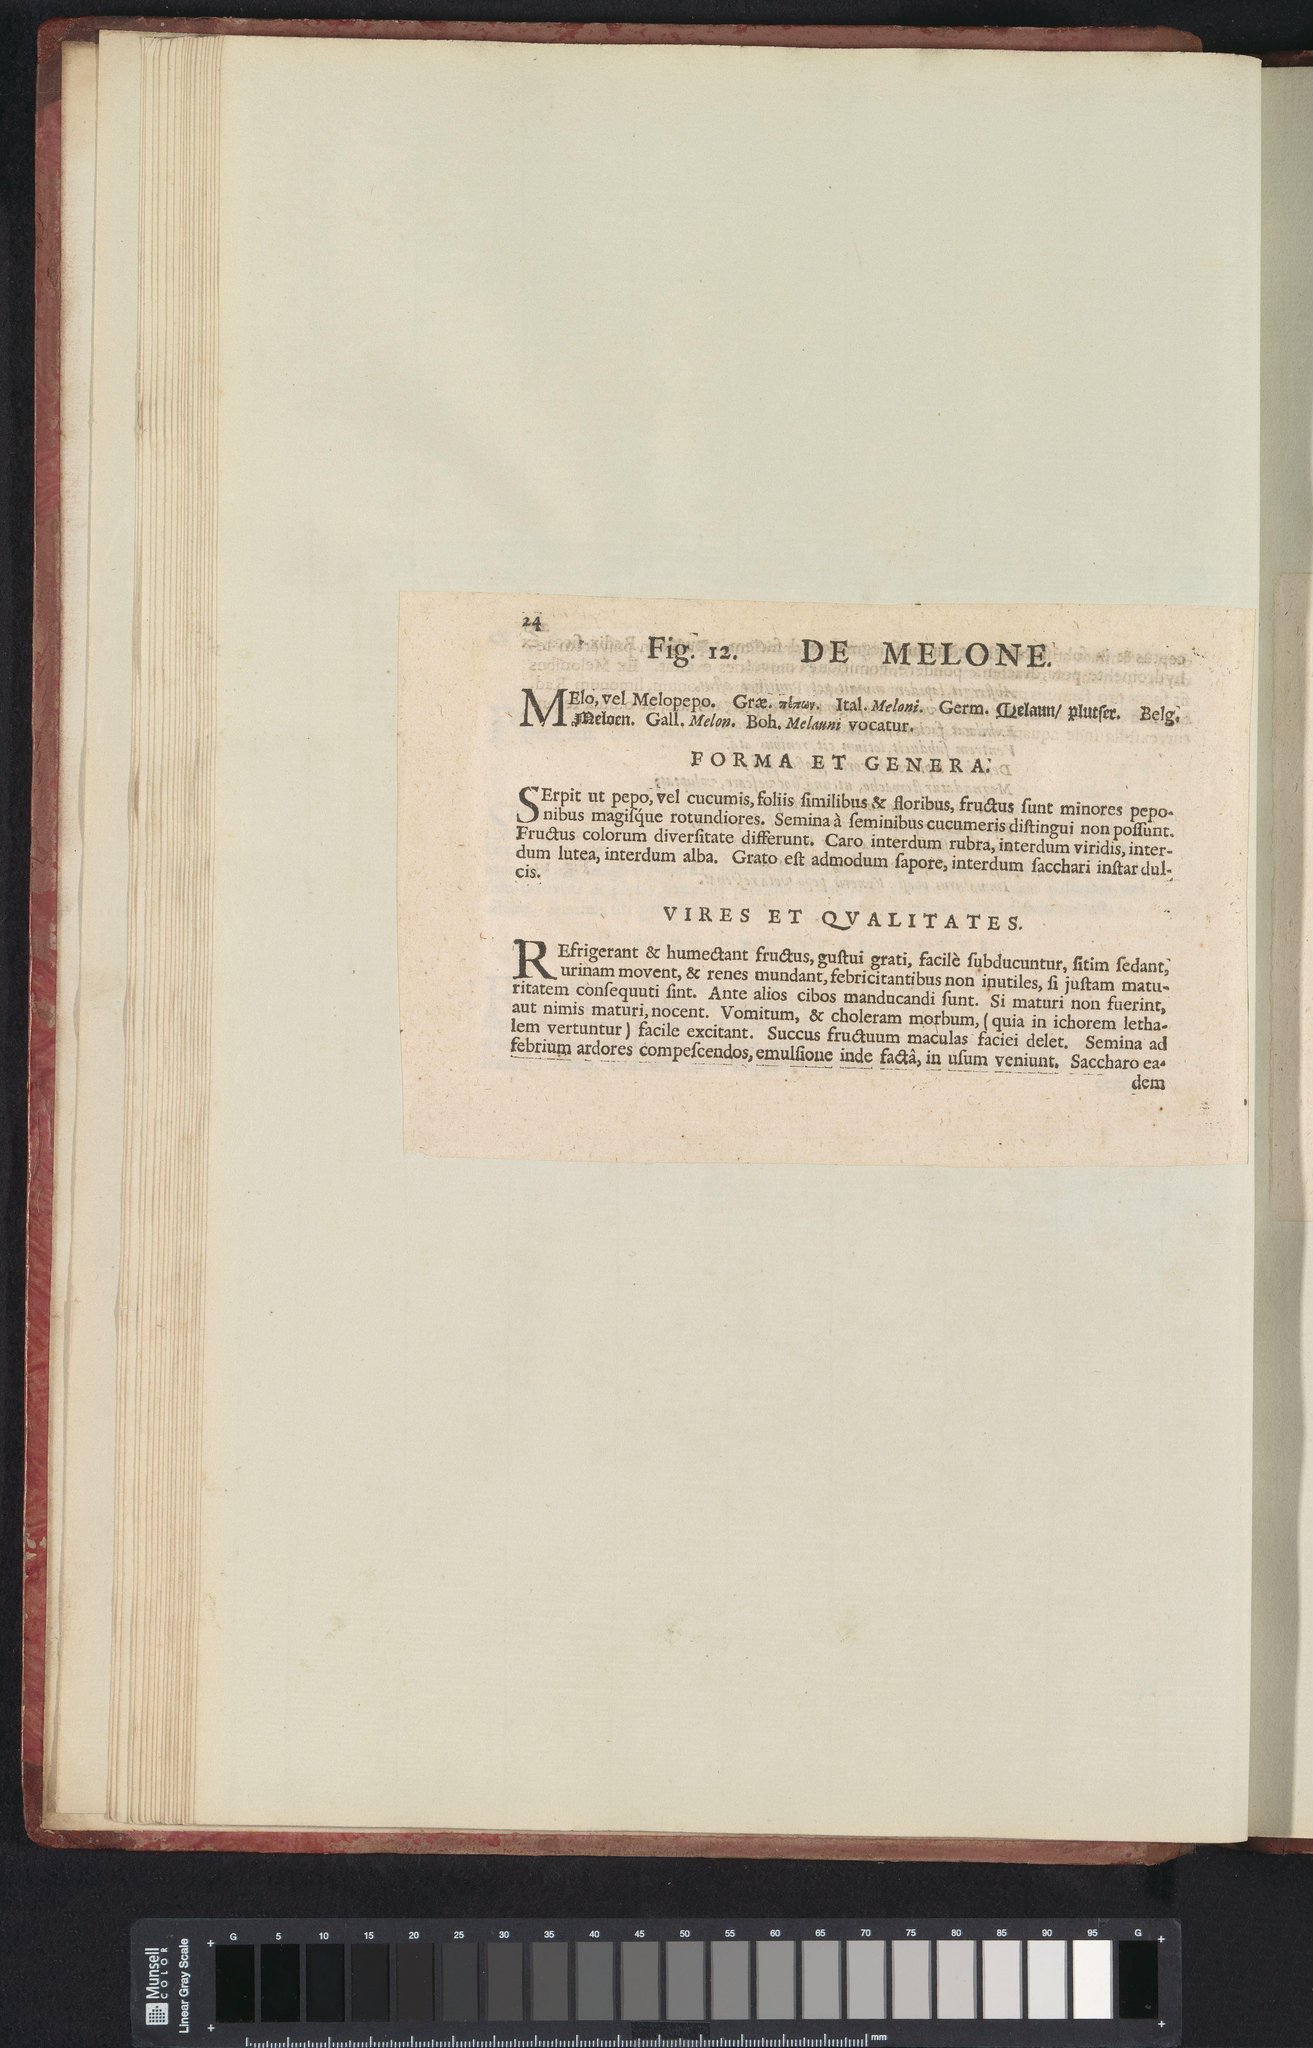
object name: text sheet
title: Fig. 12 'De Melone' in De Boodts herbarium van 1640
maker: anselmus boëtius de boodt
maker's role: draughtsman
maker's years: 1550-1632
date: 1640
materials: ink, paper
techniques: letterpress printing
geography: bruges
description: Beschrijving bij Fig. 12 op p. 24 in: Anselmi Boëtii de Boot I.C. Brugensis & Rodolphi II. Imp. Roman. medici a cubiculis Florum, Herbarum, ac fructuum selectiorum icones, & vires pleraeque hactenus ignotæ. Onderdeel van het album met bladen en platen uit De Boodts herbarium van 1640. Het twaalfde van twaalf albums met aquarellen van dieren, vogels en planten bekend rond 1600, gemaakt in opdracht van keizer Rudolf II.